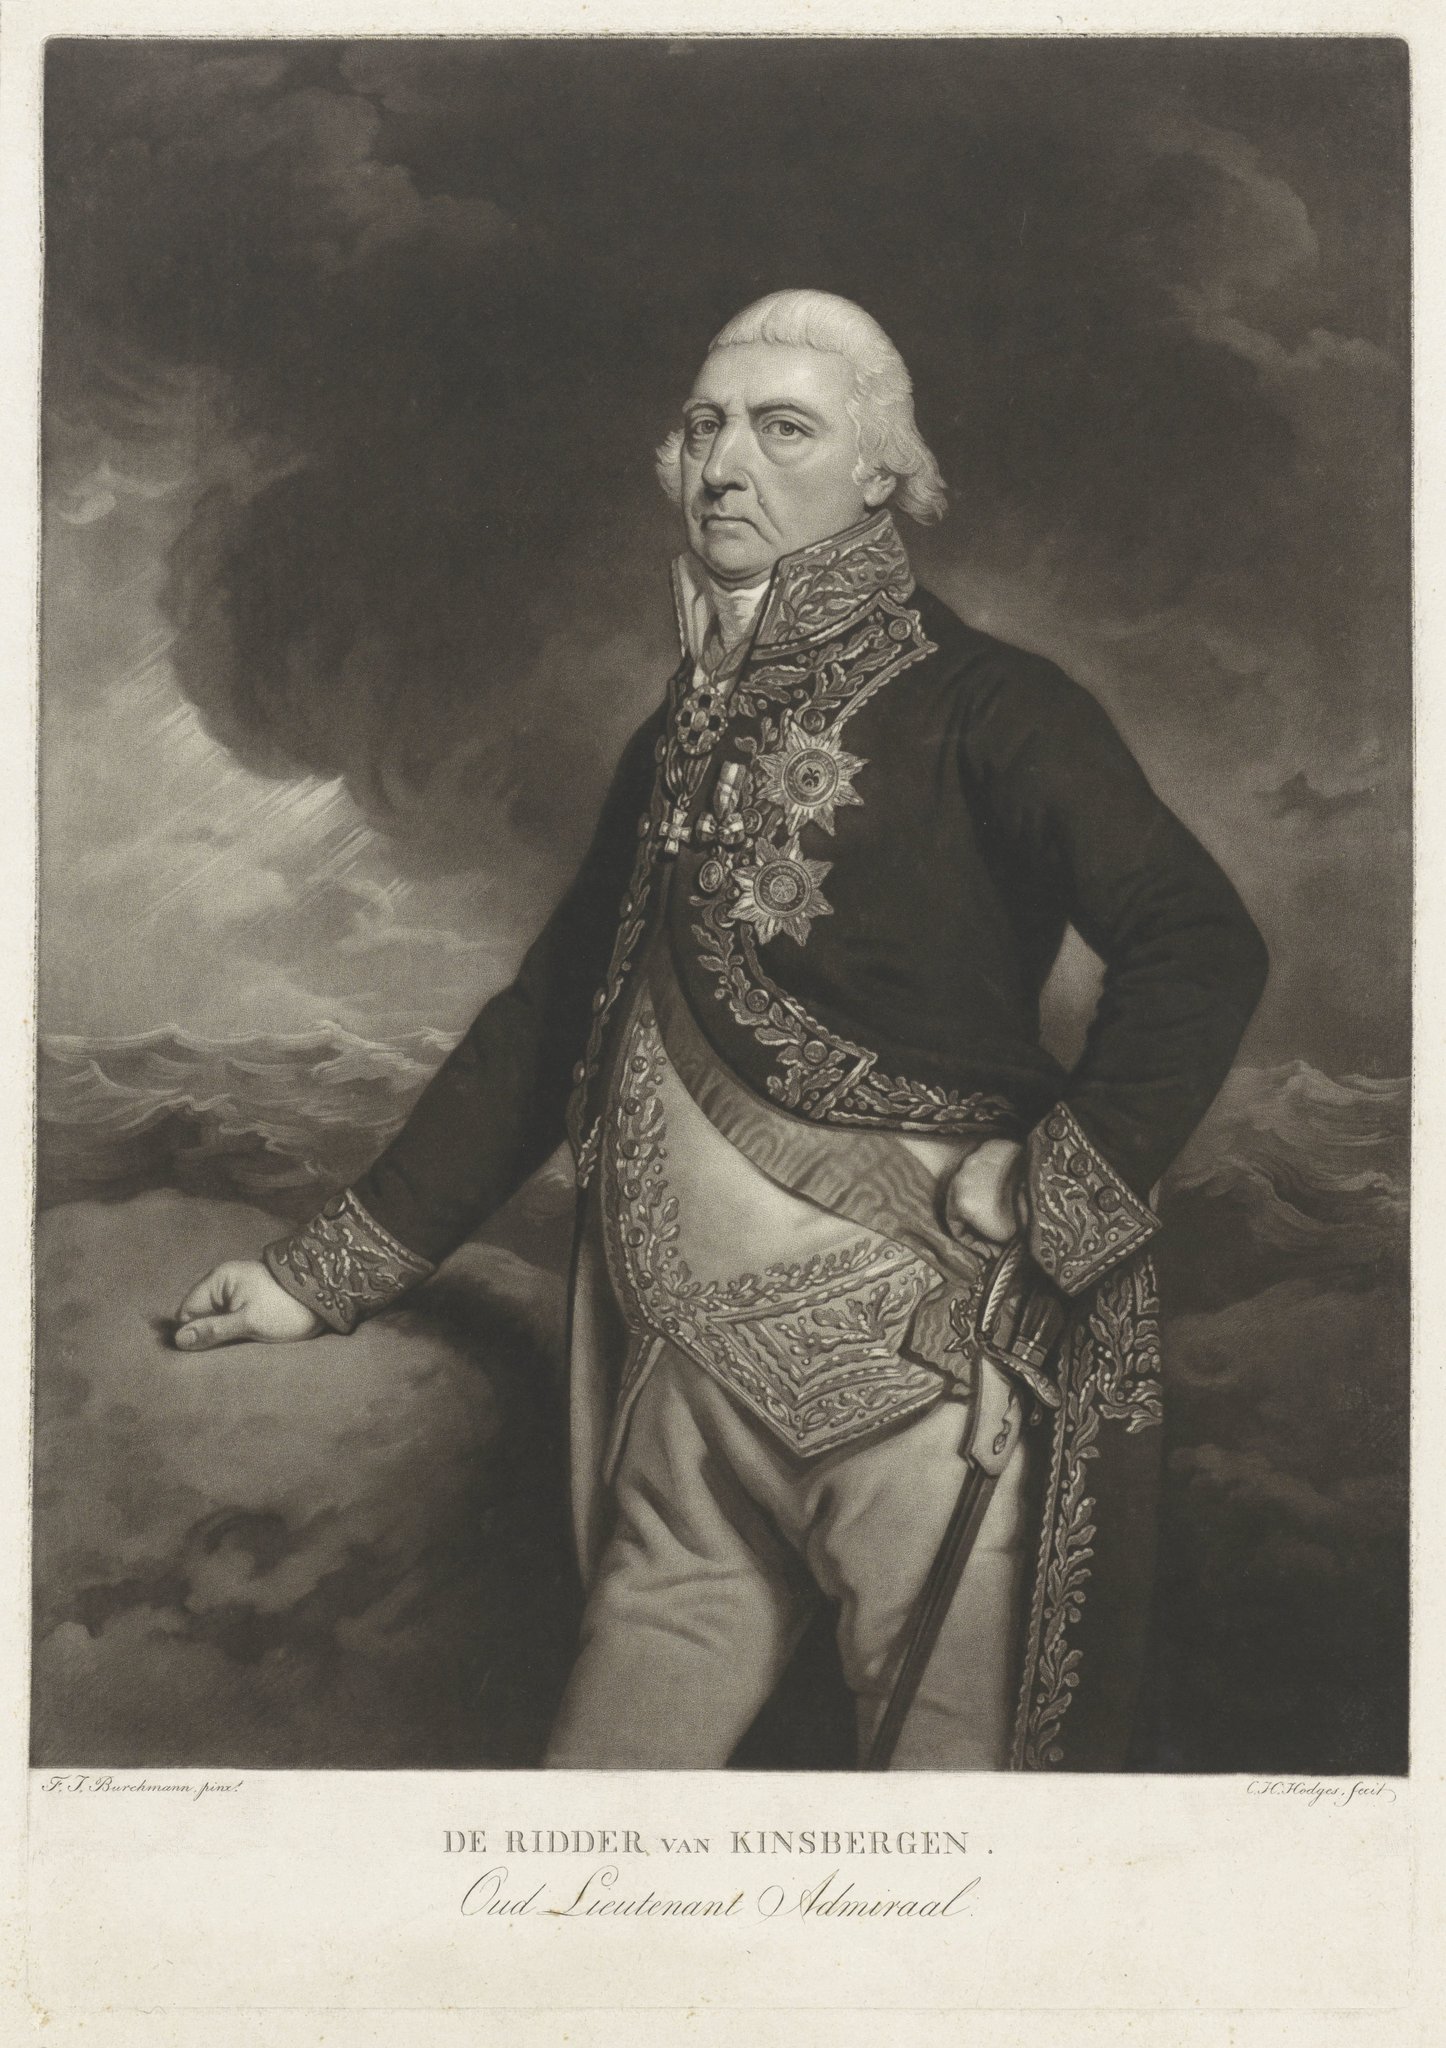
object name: print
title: Portret van admiraal Jan Hendrik van Kinsbergen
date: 1788-1837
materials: paper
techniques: engraving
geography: netherlands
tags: jonkheer jan hendrik van kinsbergen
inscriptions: collector's mark: Lugt 2228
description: Jan Hendrik van Kinsbergen, vice-admiraal en buitengewoon maarschalk der Hollandse zeemacht, met een hand in de zij.